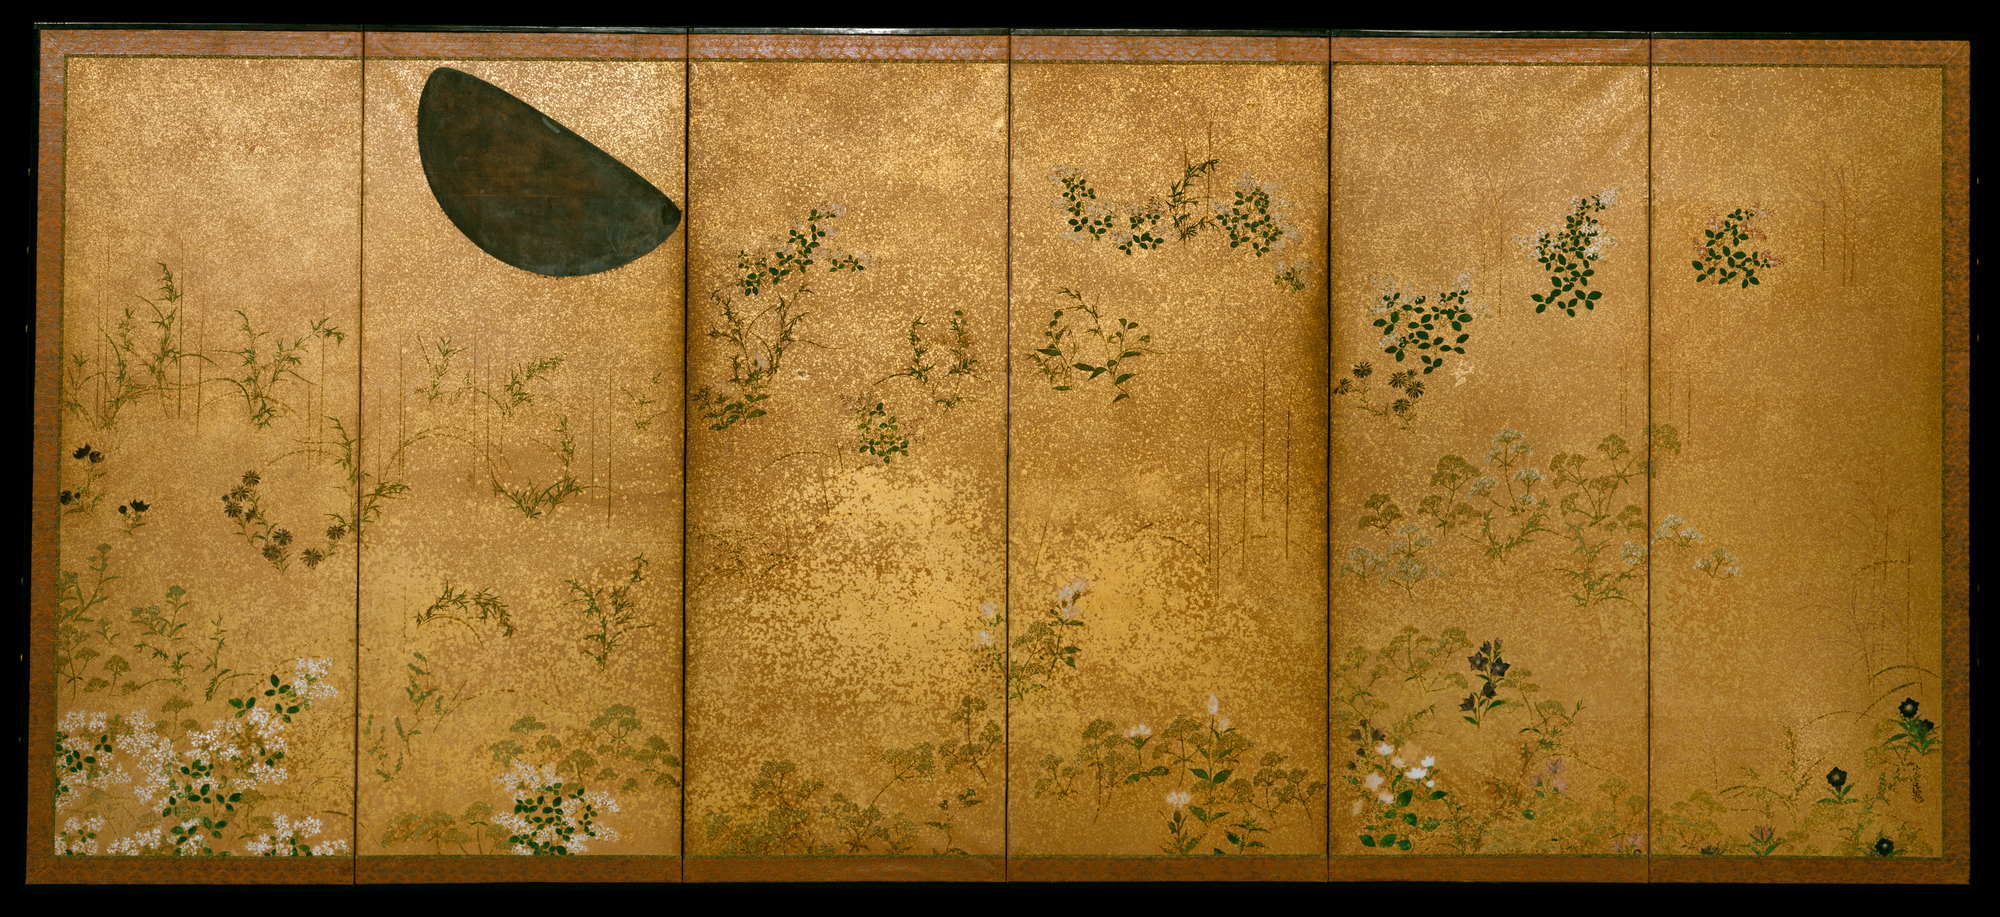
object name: screen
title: Moon and Autumn Grasses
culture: japanese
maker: tawaraya sōtatsu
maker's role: artist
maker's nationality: japanese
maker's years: 1570-1640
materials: gold, ink, panel, paper, silver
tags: moon,flowers,plants